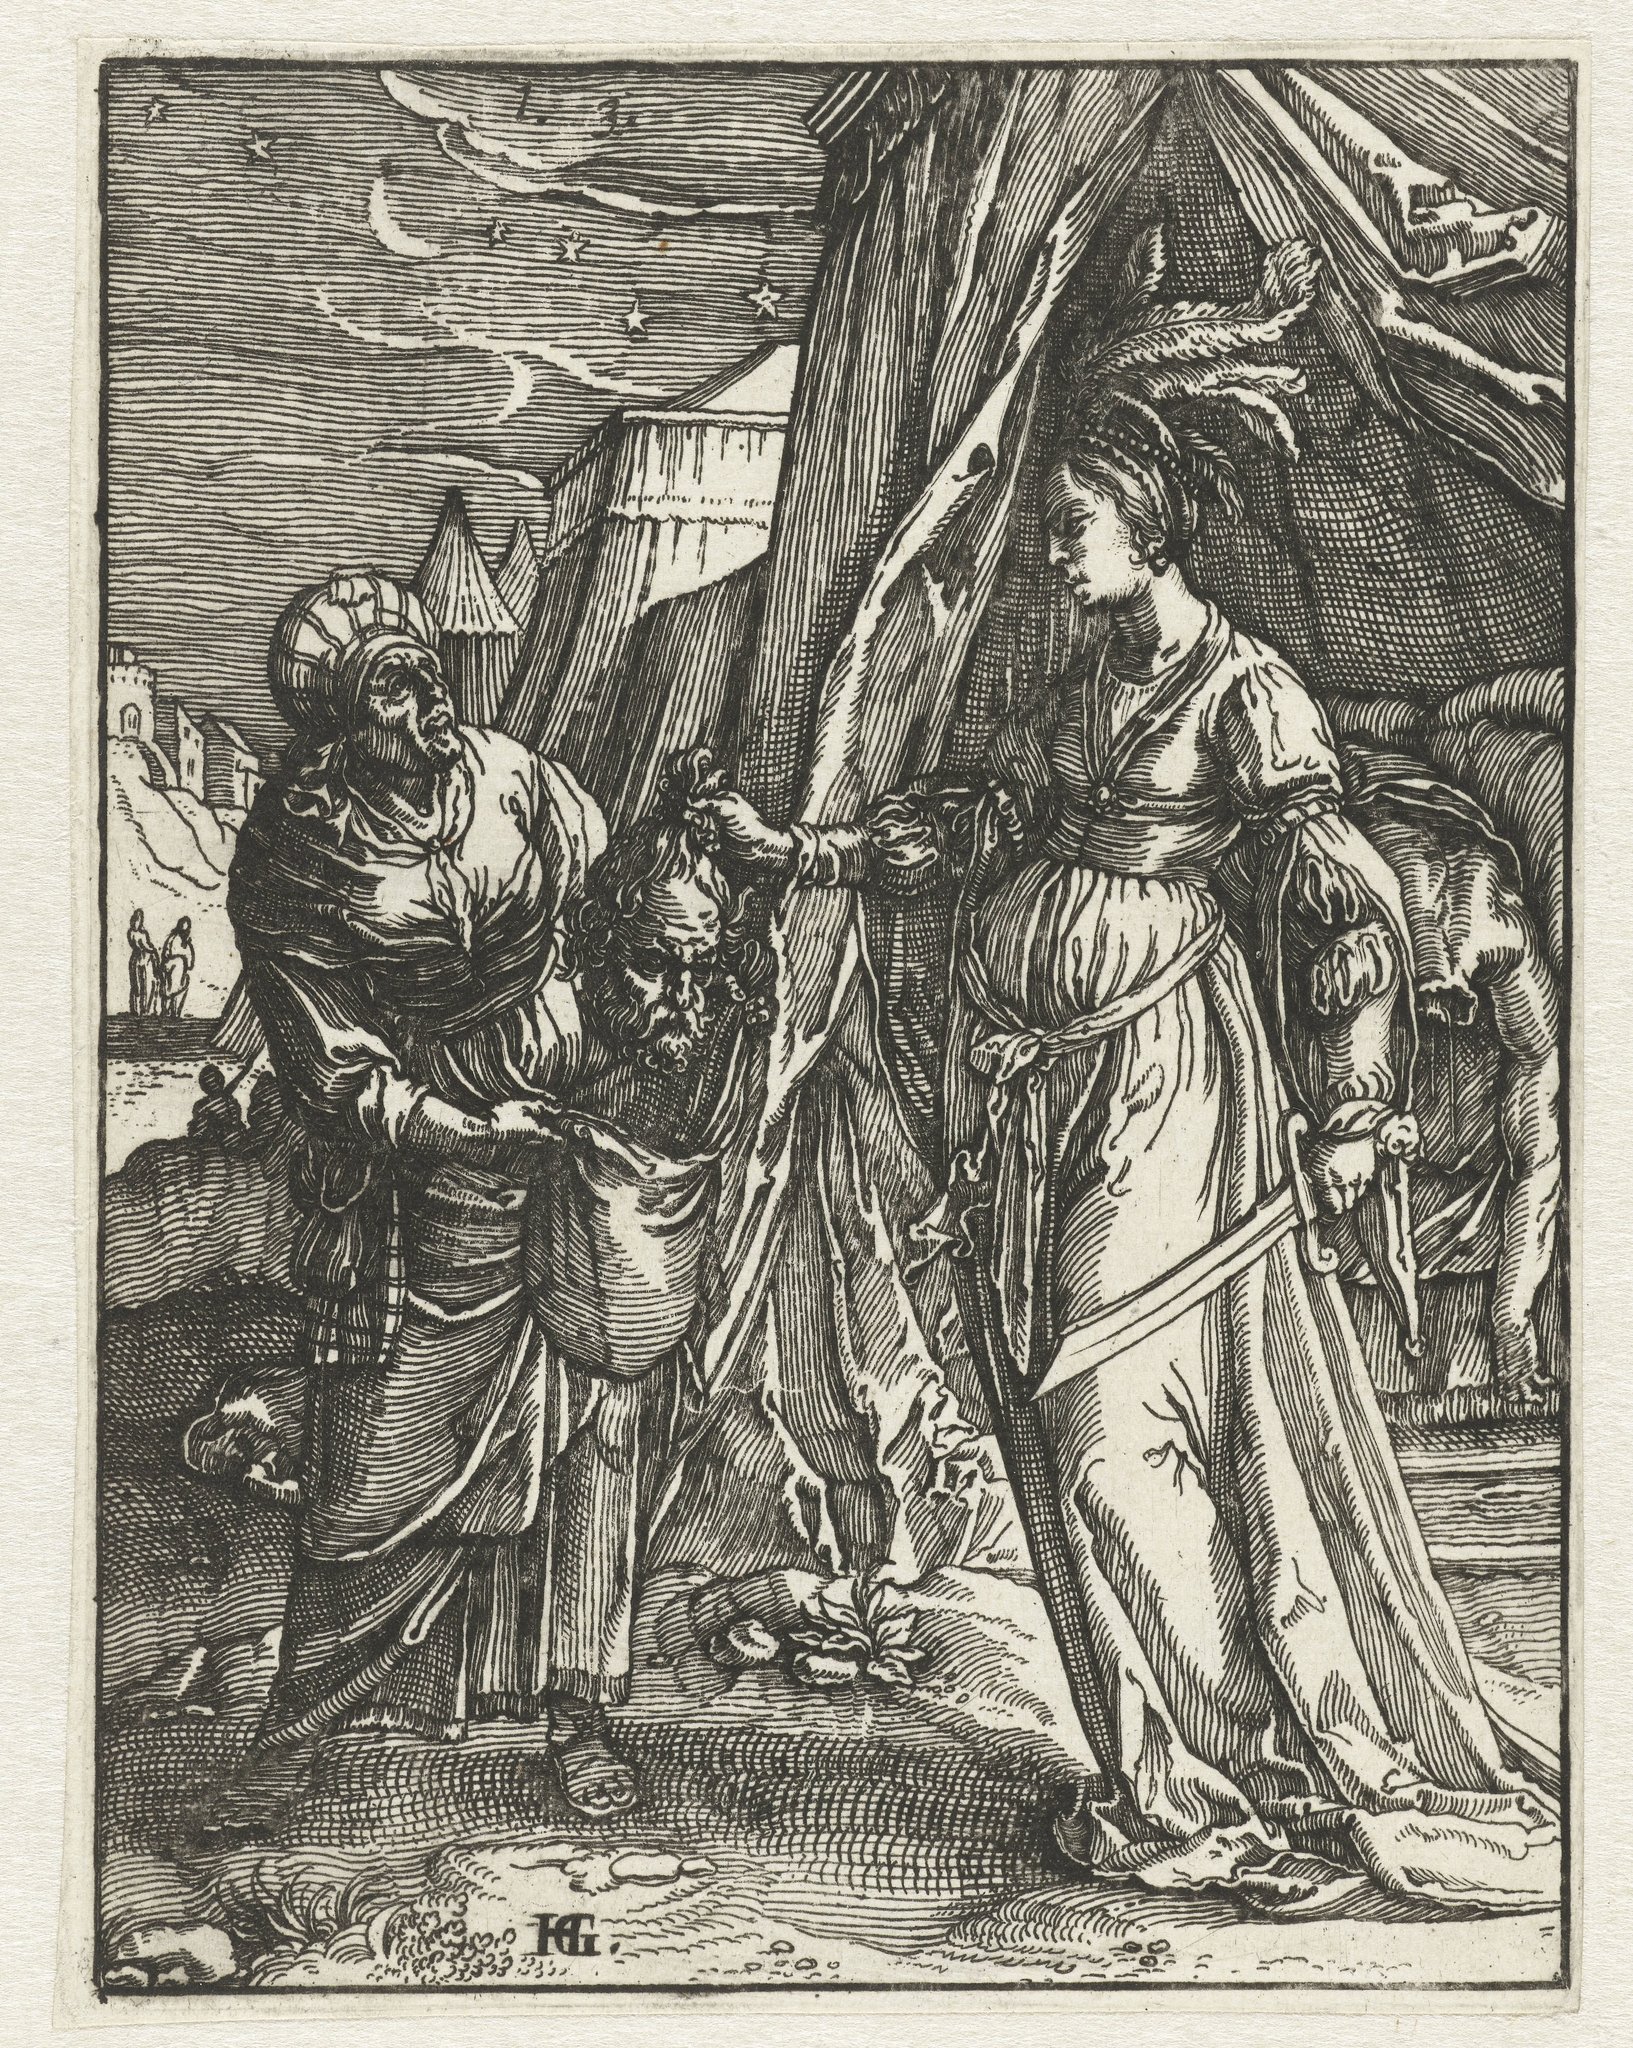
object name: print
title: Judith met het hoofd van Holofernes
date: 1600-1610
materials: paper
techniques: etching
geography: netherlands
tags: judith and holofernes (judith 8-16)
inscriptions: collector's mark: Lugt 2228a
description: Judith stopt het hoofd van Holofernes in de zak die haar dienstmaagd voor haar open houdt. Rechts achter hen, in zijn tent, het verminkte lijf van Holofernes. Linksboven 'l' en 'z'.